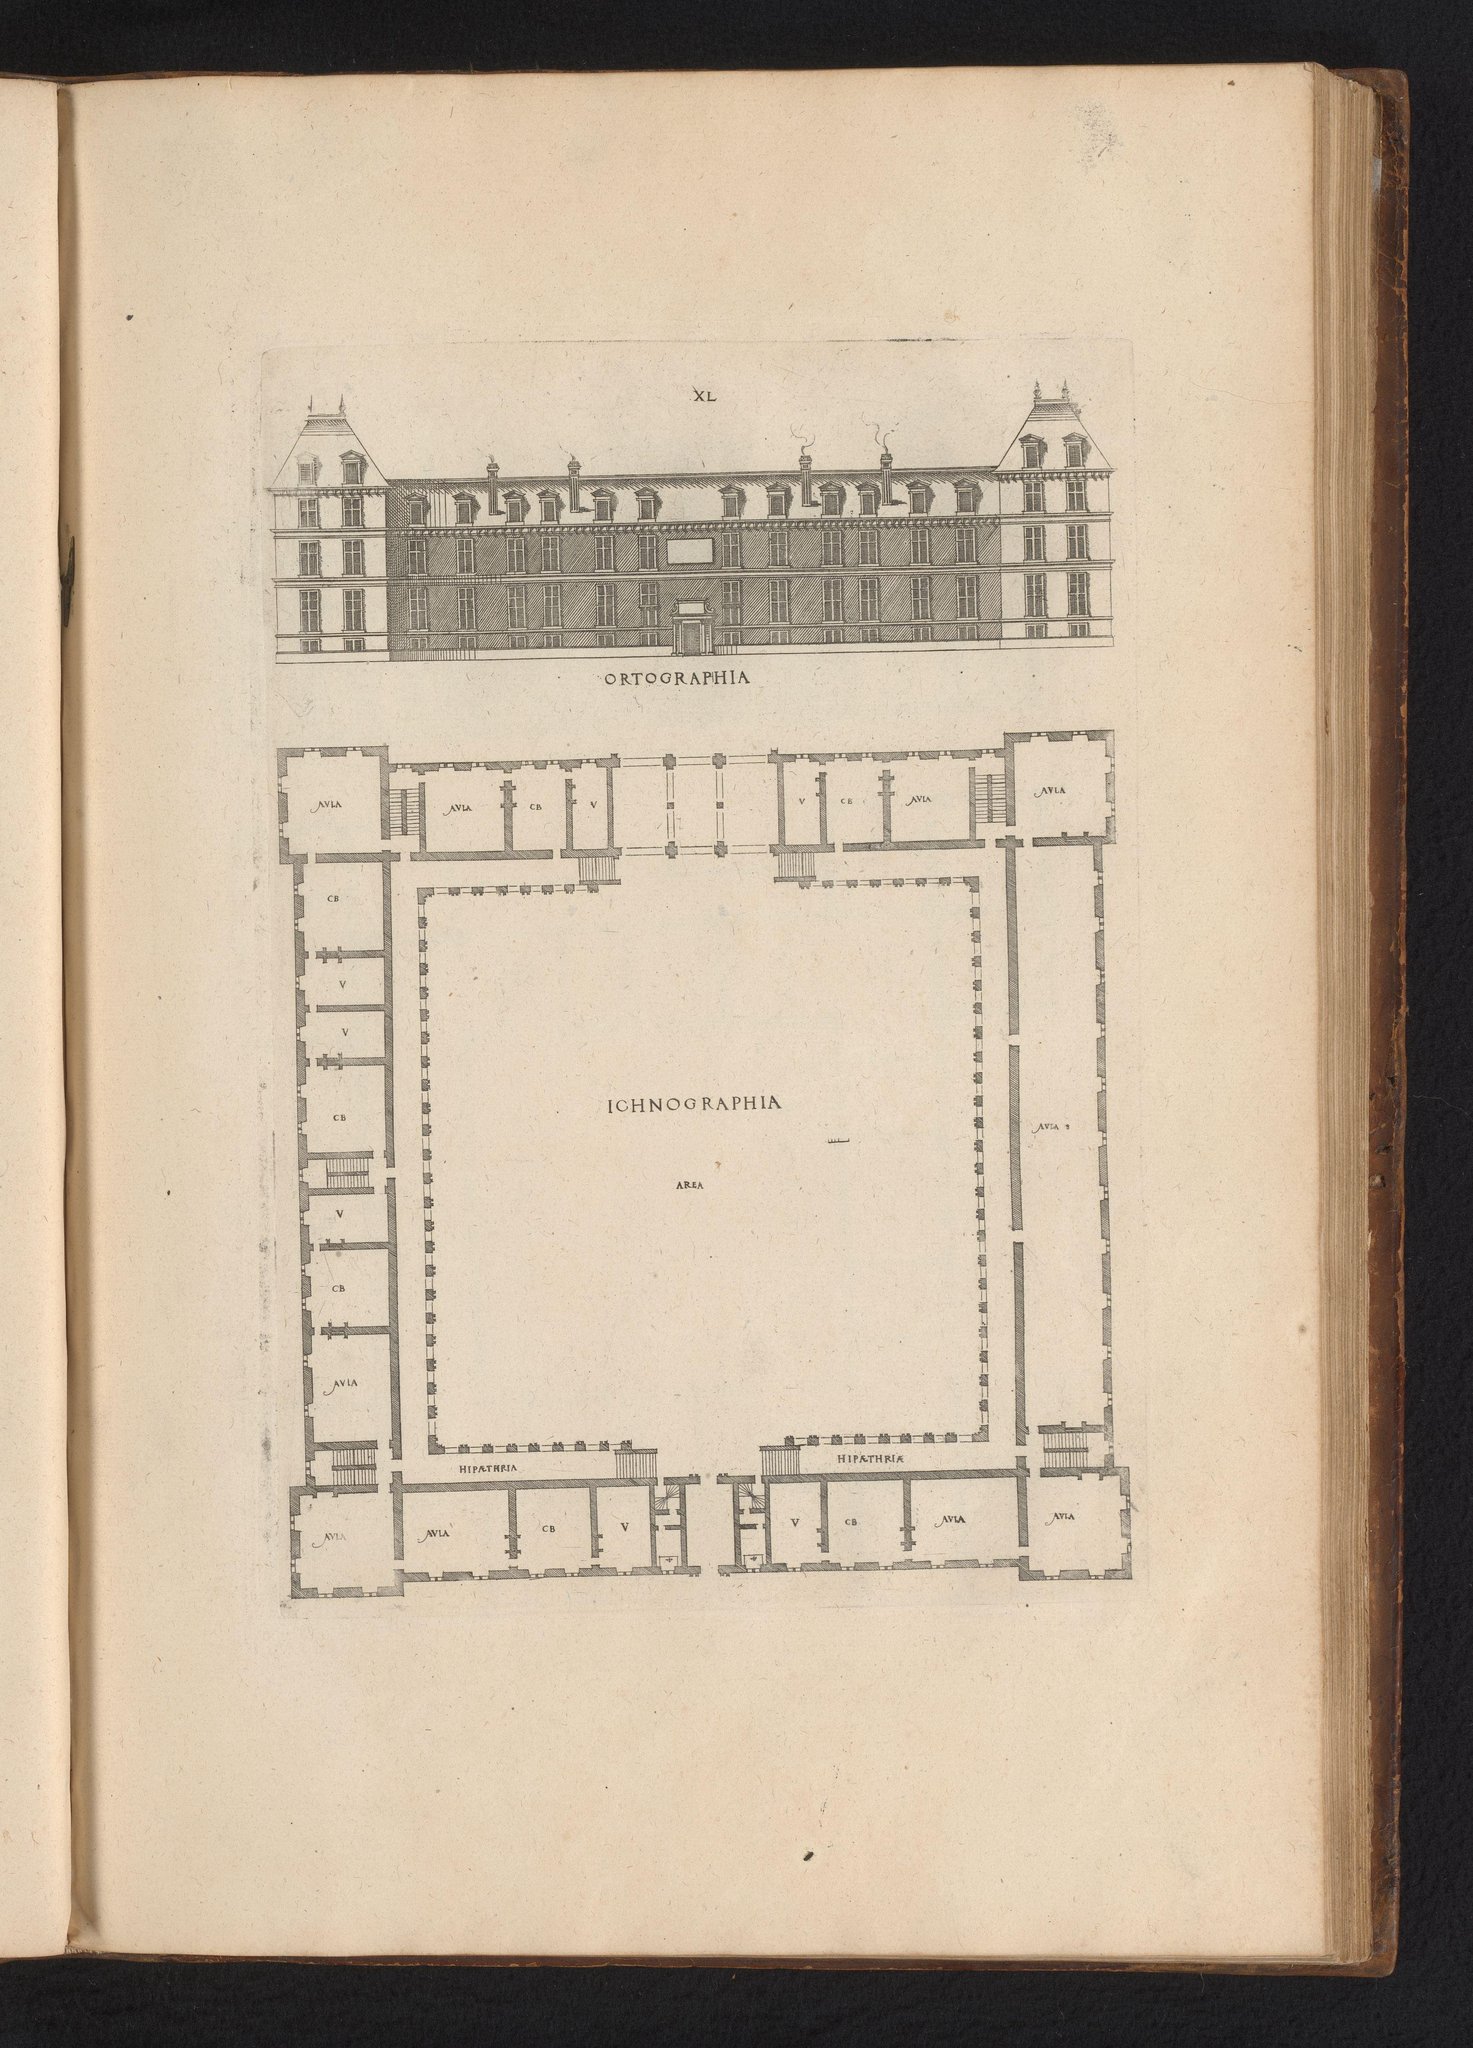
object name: ornament print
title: Aanzicht en plattegrond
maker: jacques androuet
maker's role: draughtsman, print maker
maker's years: 1515-1584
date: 1559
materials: paper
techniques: etching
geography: paris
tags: façade (of house or building), plan ~ architecture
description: Aanzicht en plattegrond van architectuur. Genummerd: XL. Onderdeel van 'De architectura Iacobi Androuetii du Cerceau' (1559): 69 etsen met 171 voorstellingen van architectuur en ornamentiek.